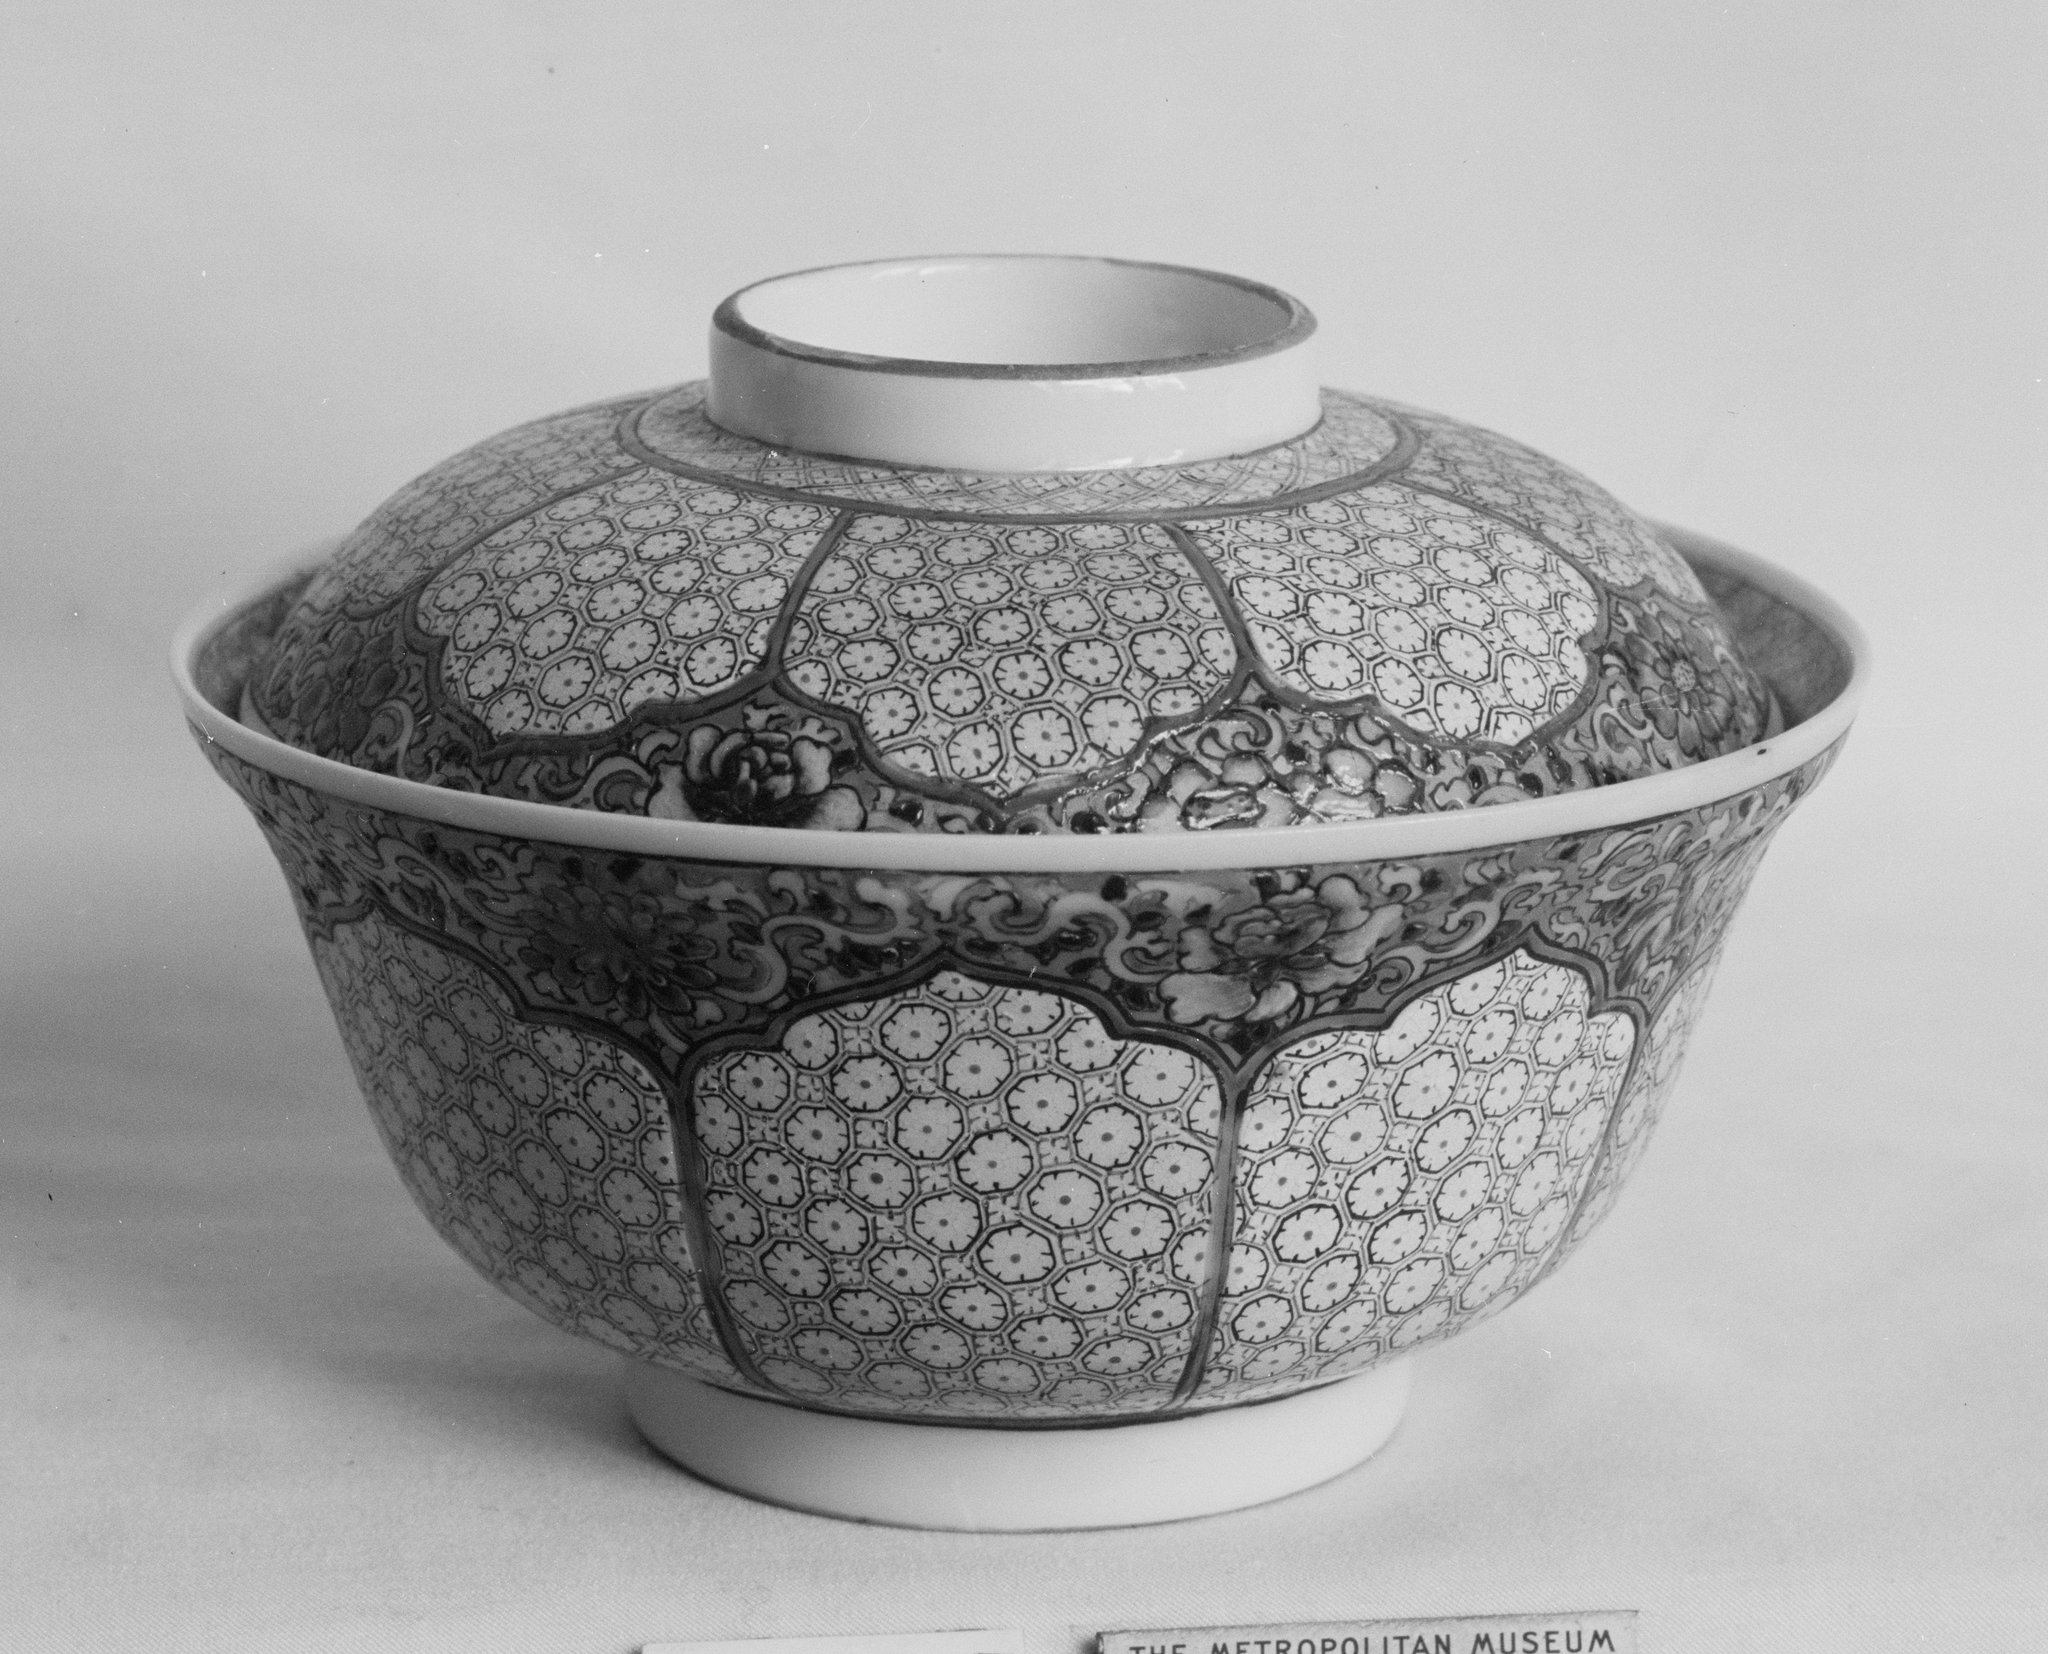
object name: covered cup and saucer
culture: chinese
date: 1736-1795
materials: porcelain, shell